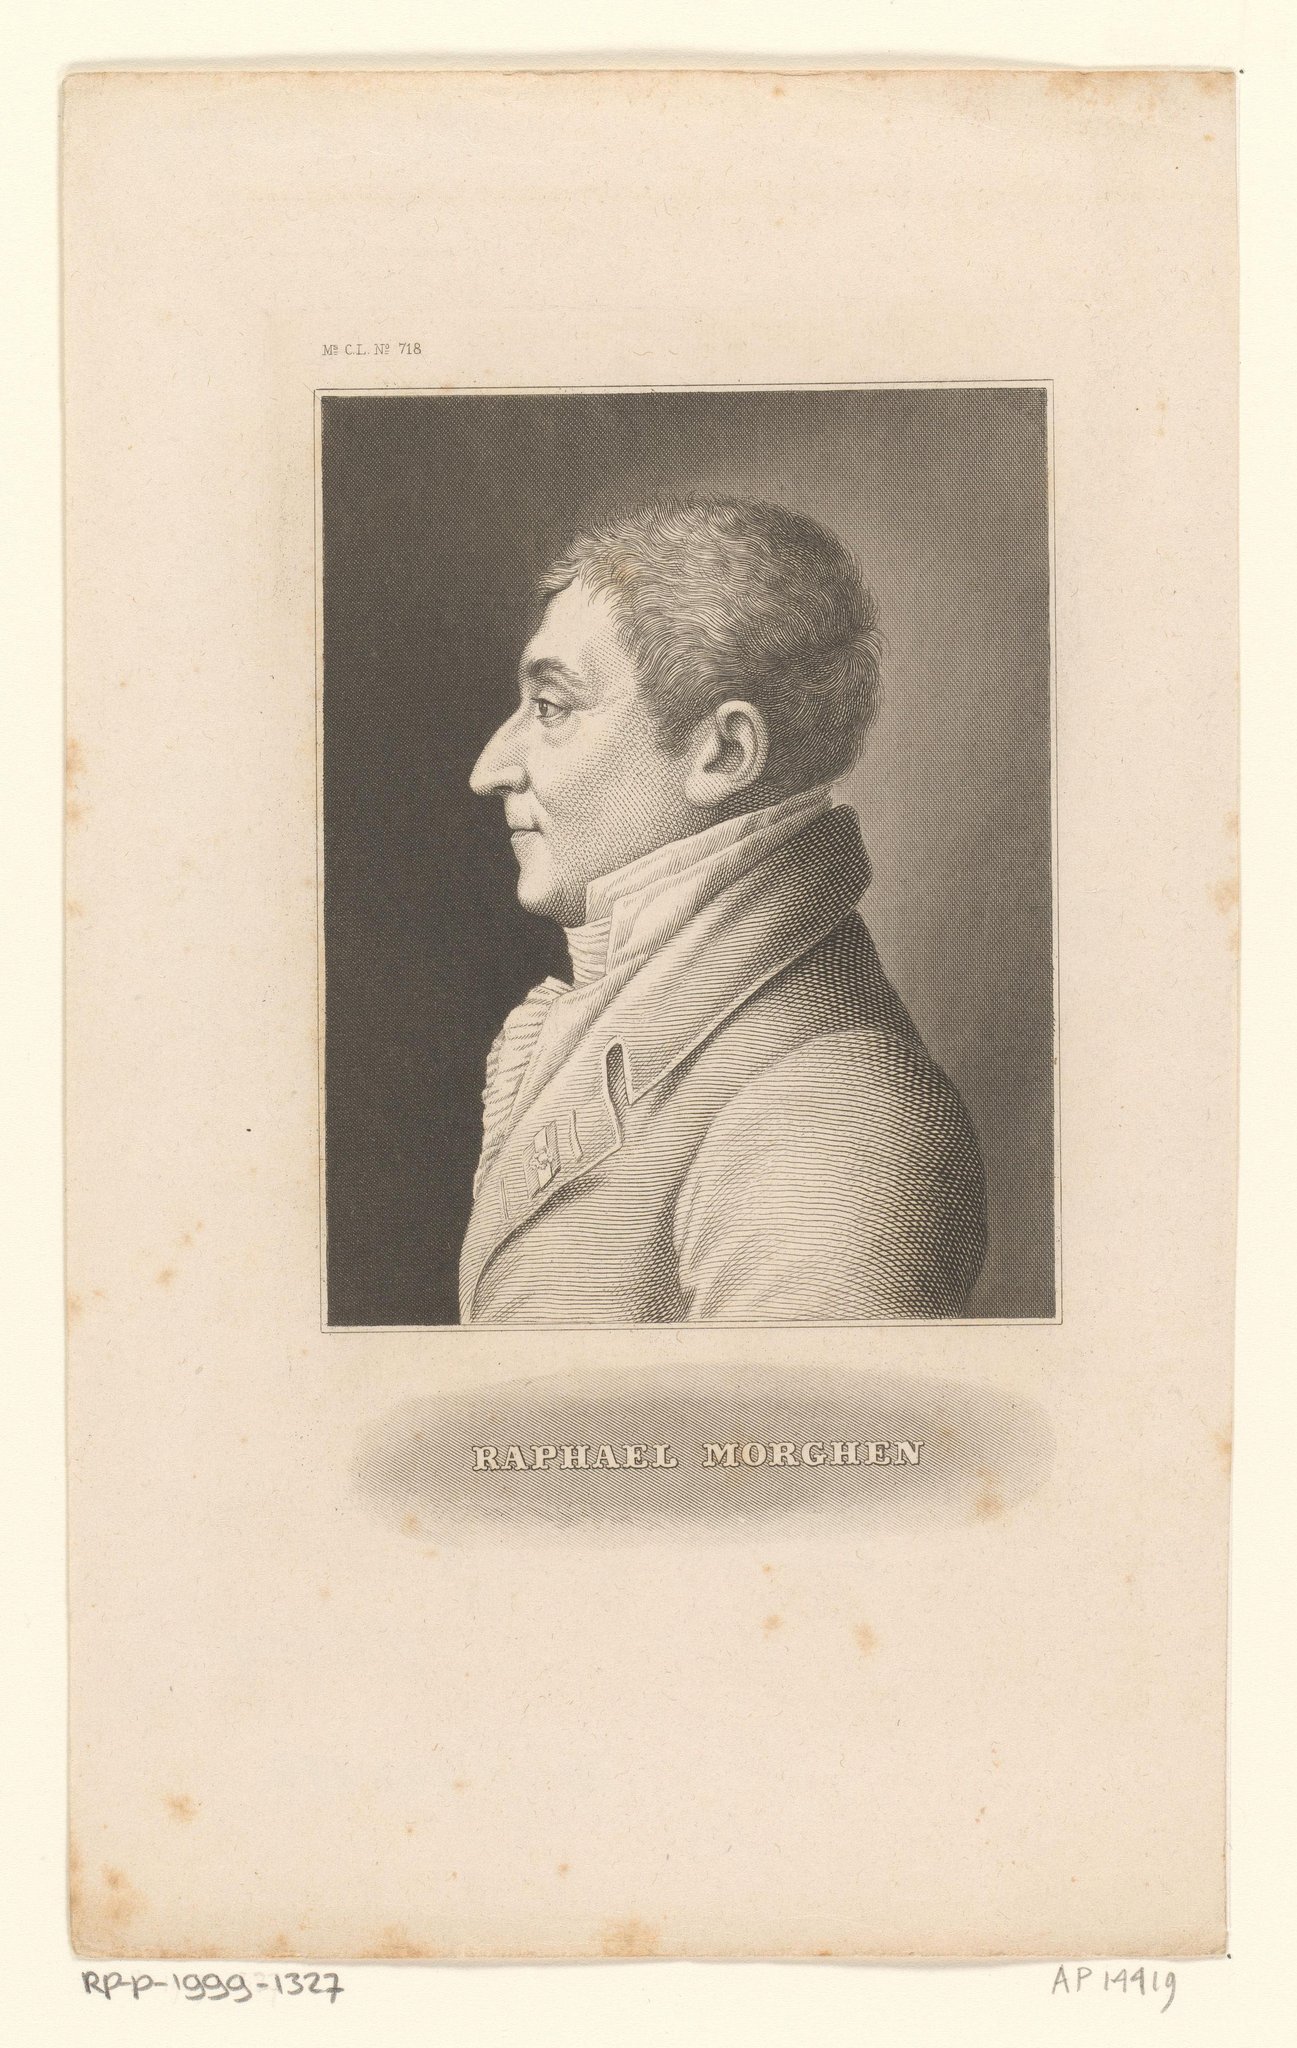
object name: print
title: Raphael Morghen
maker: Anonymous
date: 1778-1900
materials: paper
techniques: engraving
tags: painter, print maker, draughtsman, raphael morghen, historical persons, portrait, self-portrait of graphic artist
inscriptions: collector's mark: Lugt 2760, collector's mark: Lugt 2228